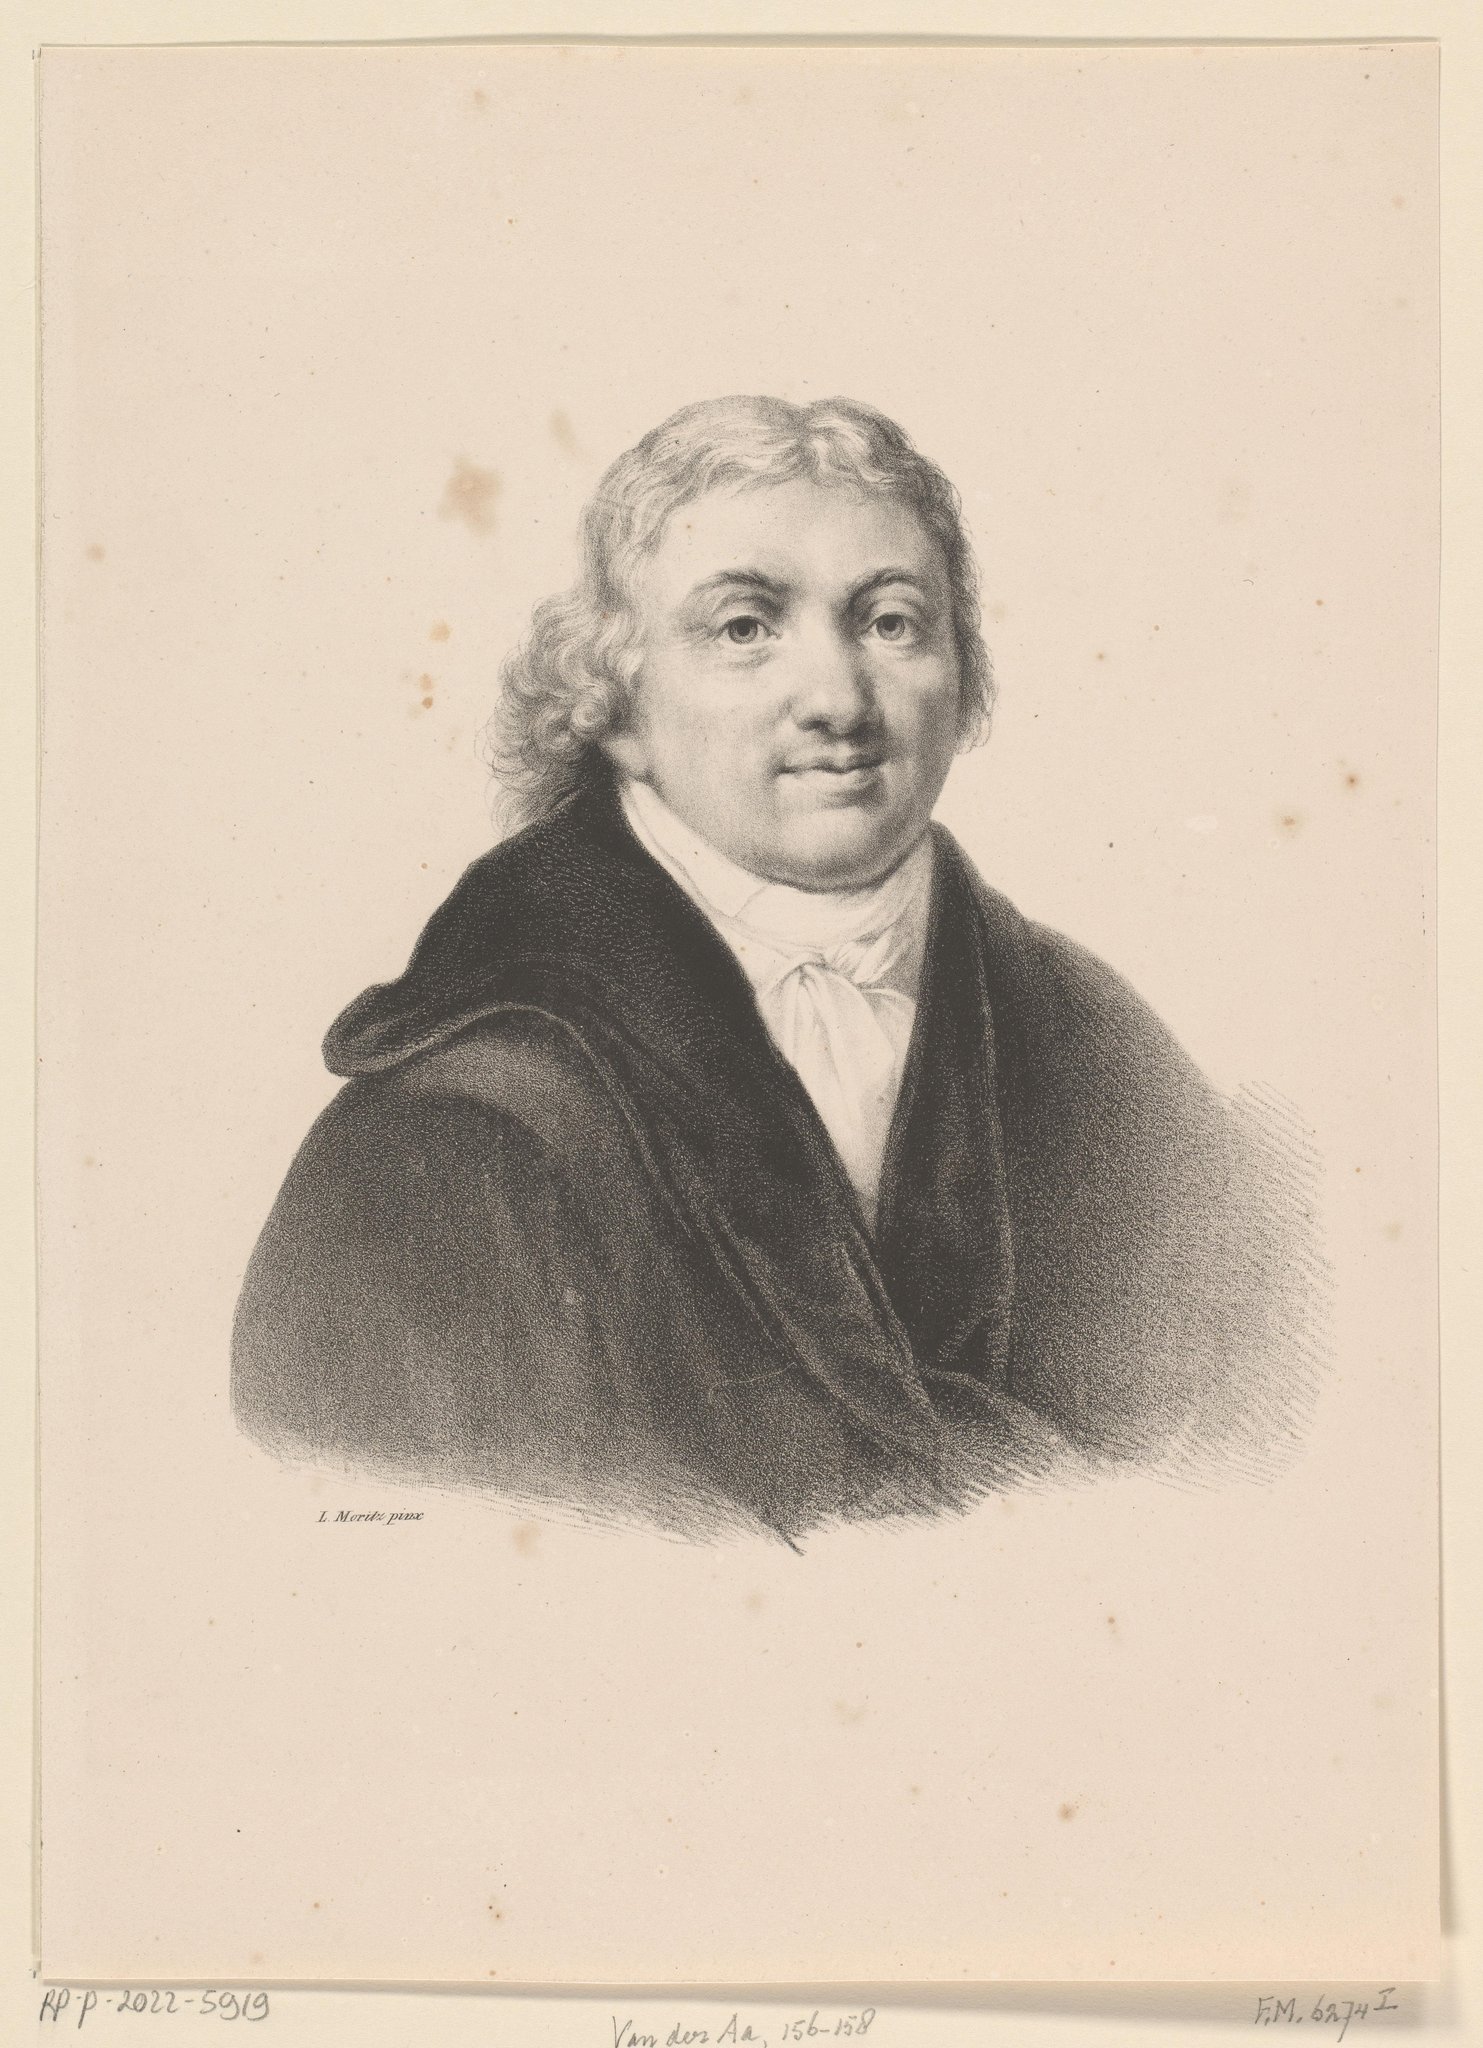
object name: print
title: Portret van Daniël Wyttenbach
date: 1801-1849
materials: paper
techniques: lithograph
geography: amsterdam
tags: historical persons, professor